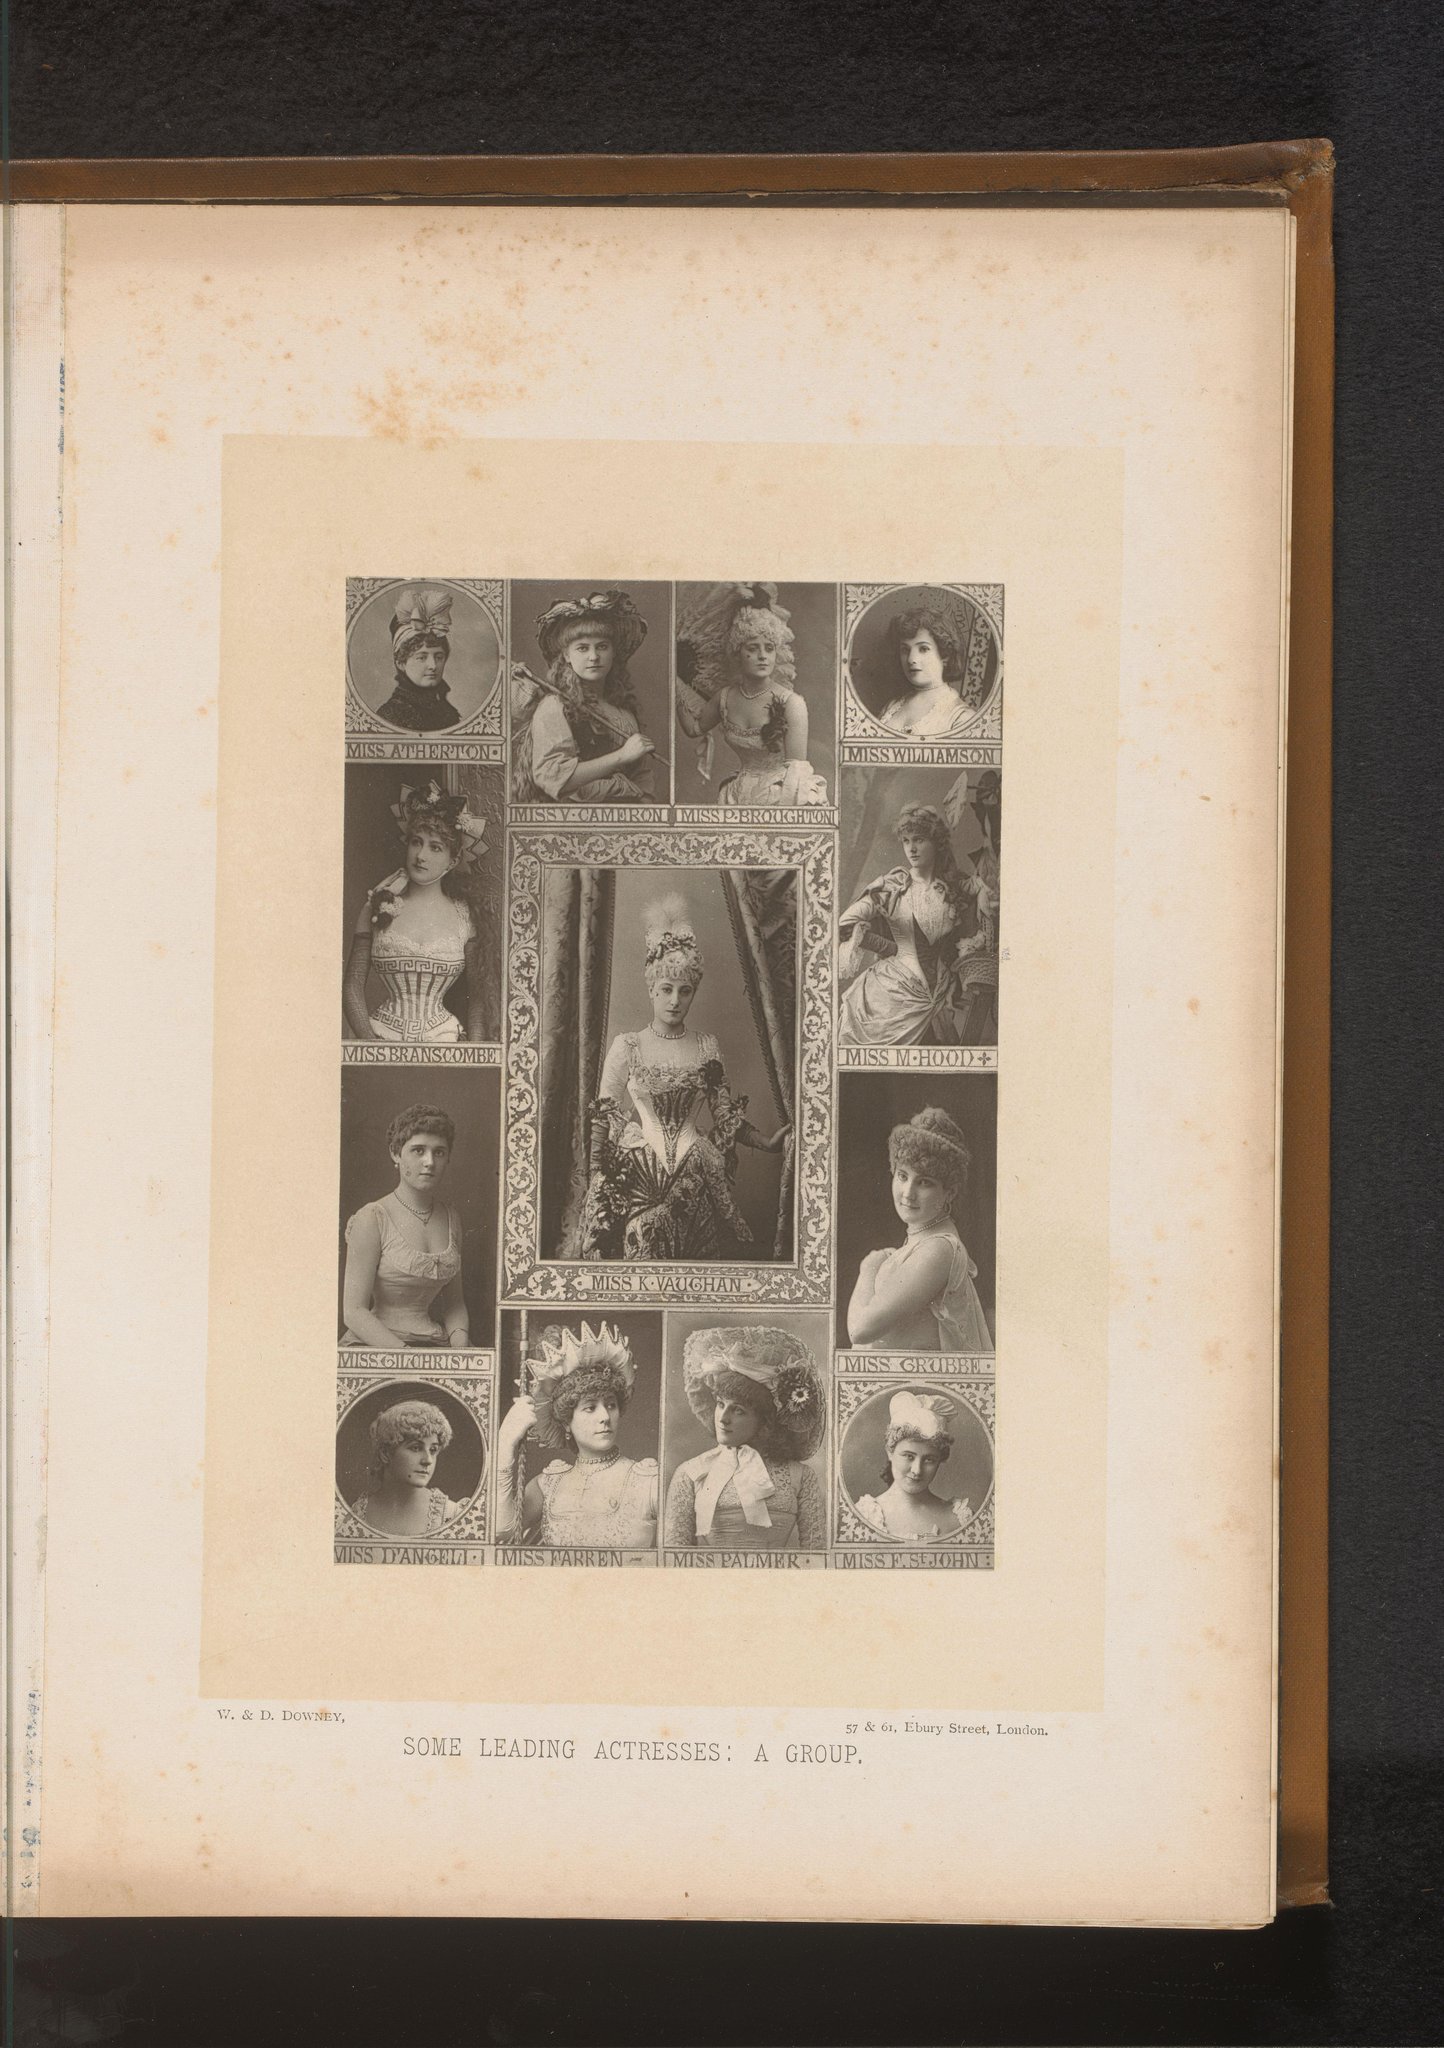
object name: page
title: Some leading actresses: A group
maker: Anonymous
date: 1880-1890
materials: paper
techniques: woodburytype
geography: london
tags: portrait of actor, actress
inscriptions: inscription: ‘57 & 61, Elbury Street, London.’, name: ‘Miss Atherton. Miss y. Cameron. MMiss p. Broughton Miss Williamson Miss M. Hood. Miss Branscombe Miss K. Vaughan. Miss Gilchrist. Miss Grubbe. Miss D'angeli. Miss Farren. Miss Palmer. Miss F. St John.’